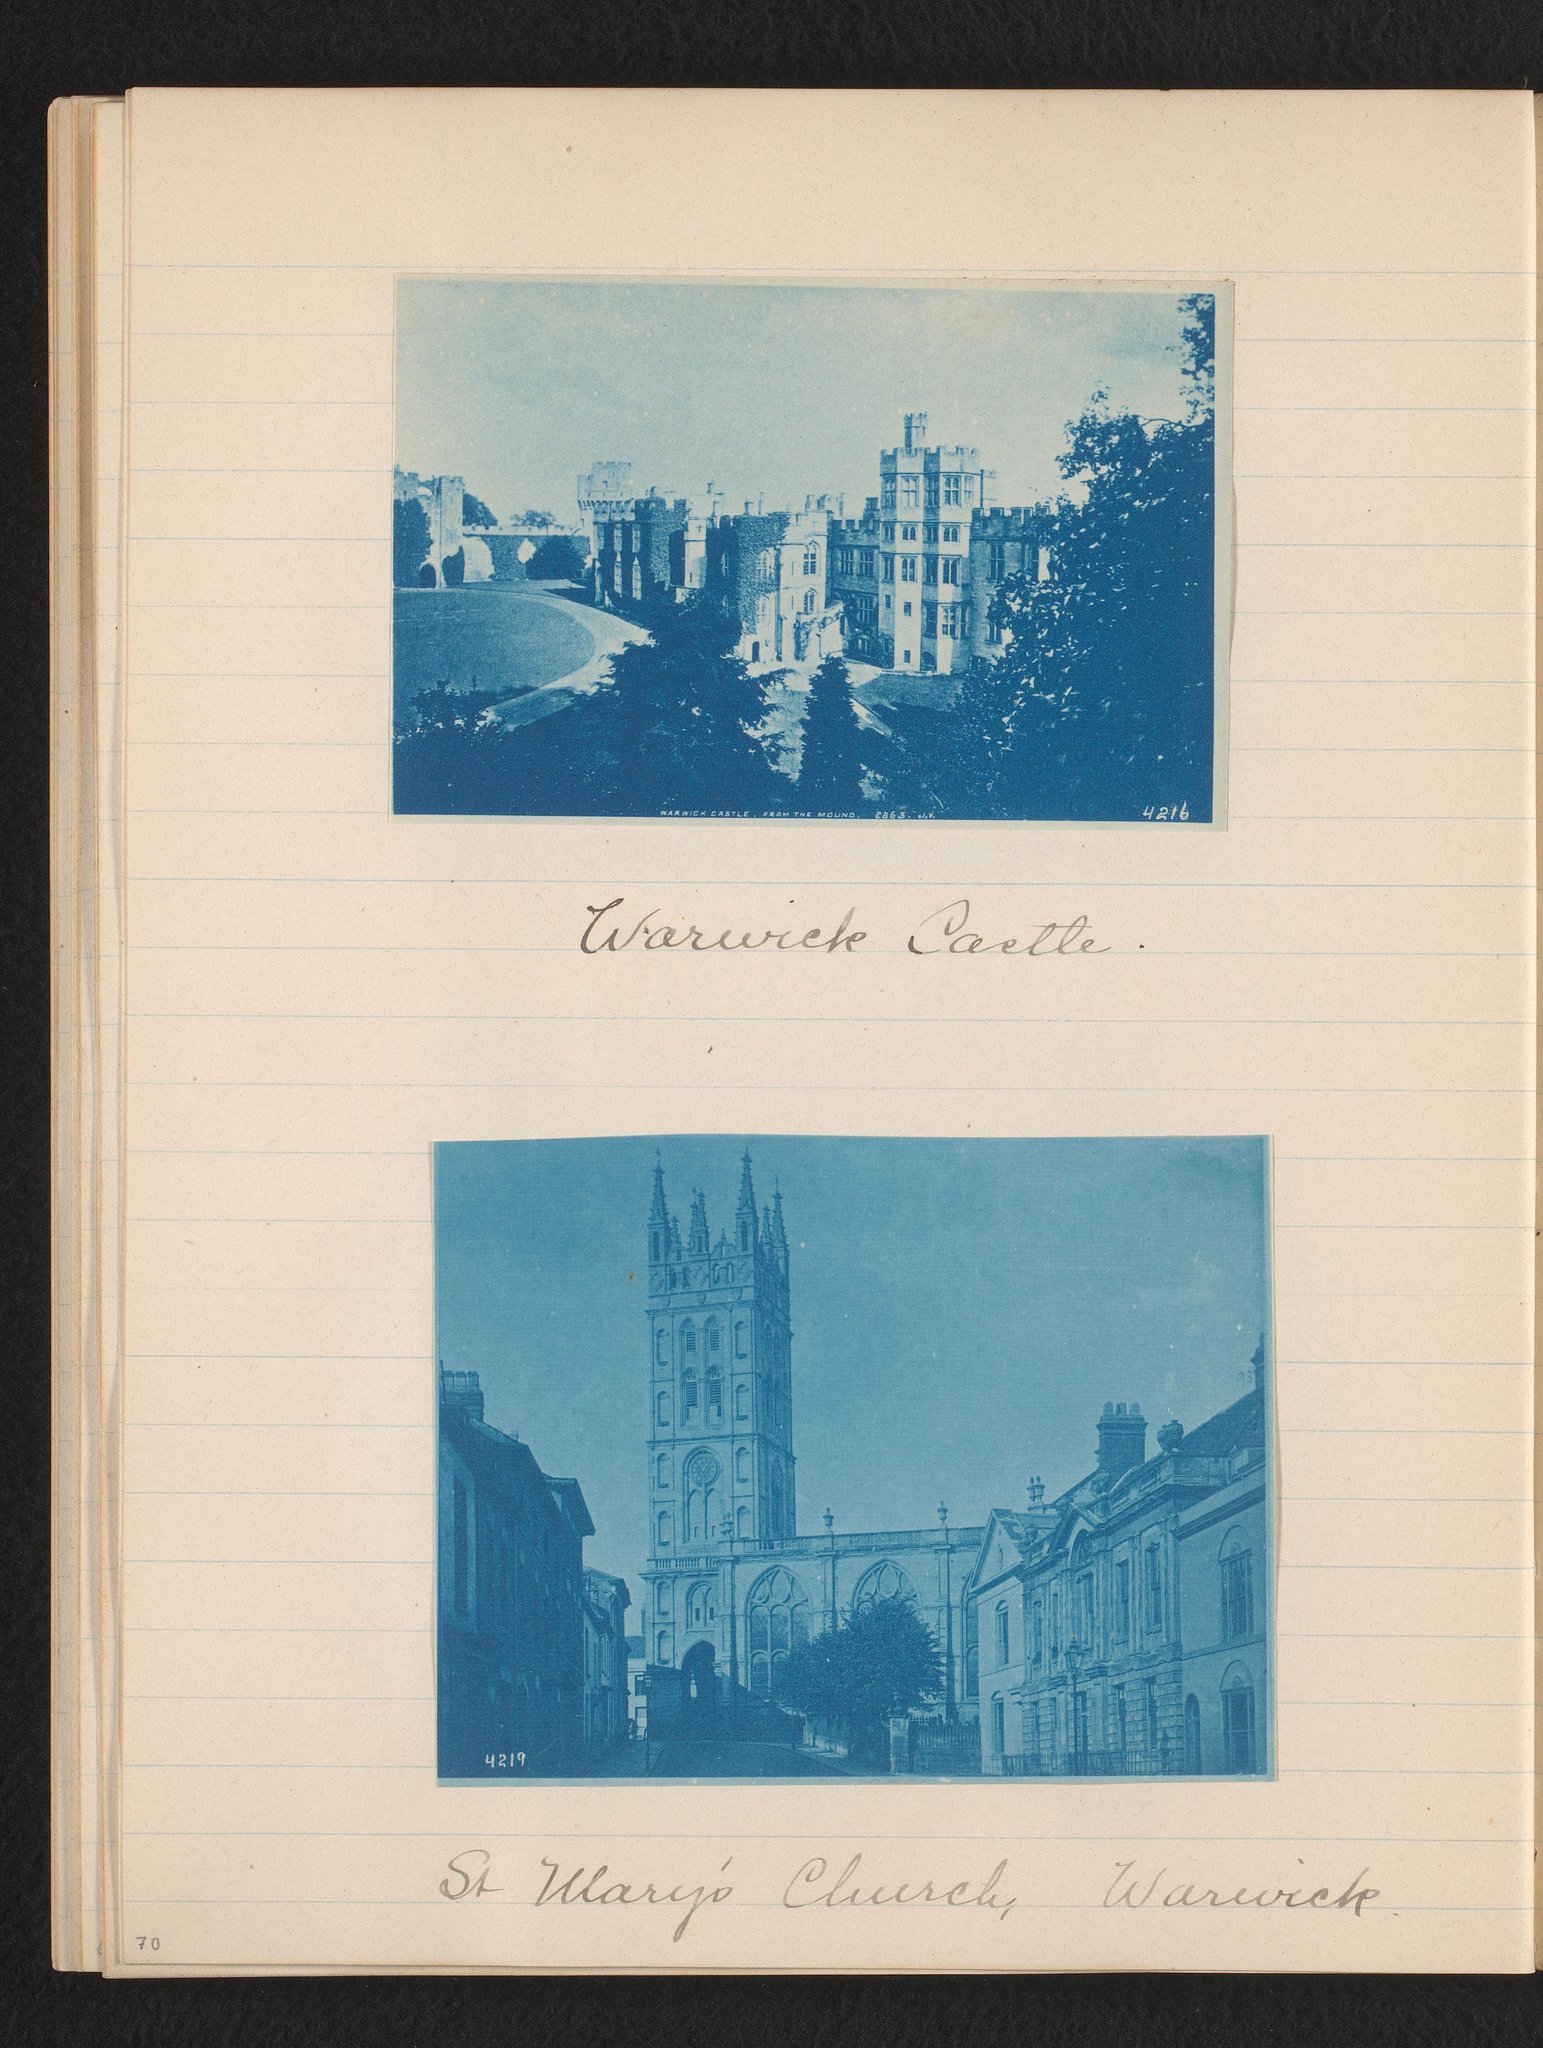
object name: album leaf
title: Twee foto's van het kasteel en de kerk van Warwick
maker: Anonymous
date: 1901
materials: paper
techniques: cyanotype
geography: warwick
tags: castle, church (exterior)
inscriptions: inscription: ‘Warwick Castle./ St Mary's Church, Warwick.’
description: Deze foto's maken deel uit van een album.